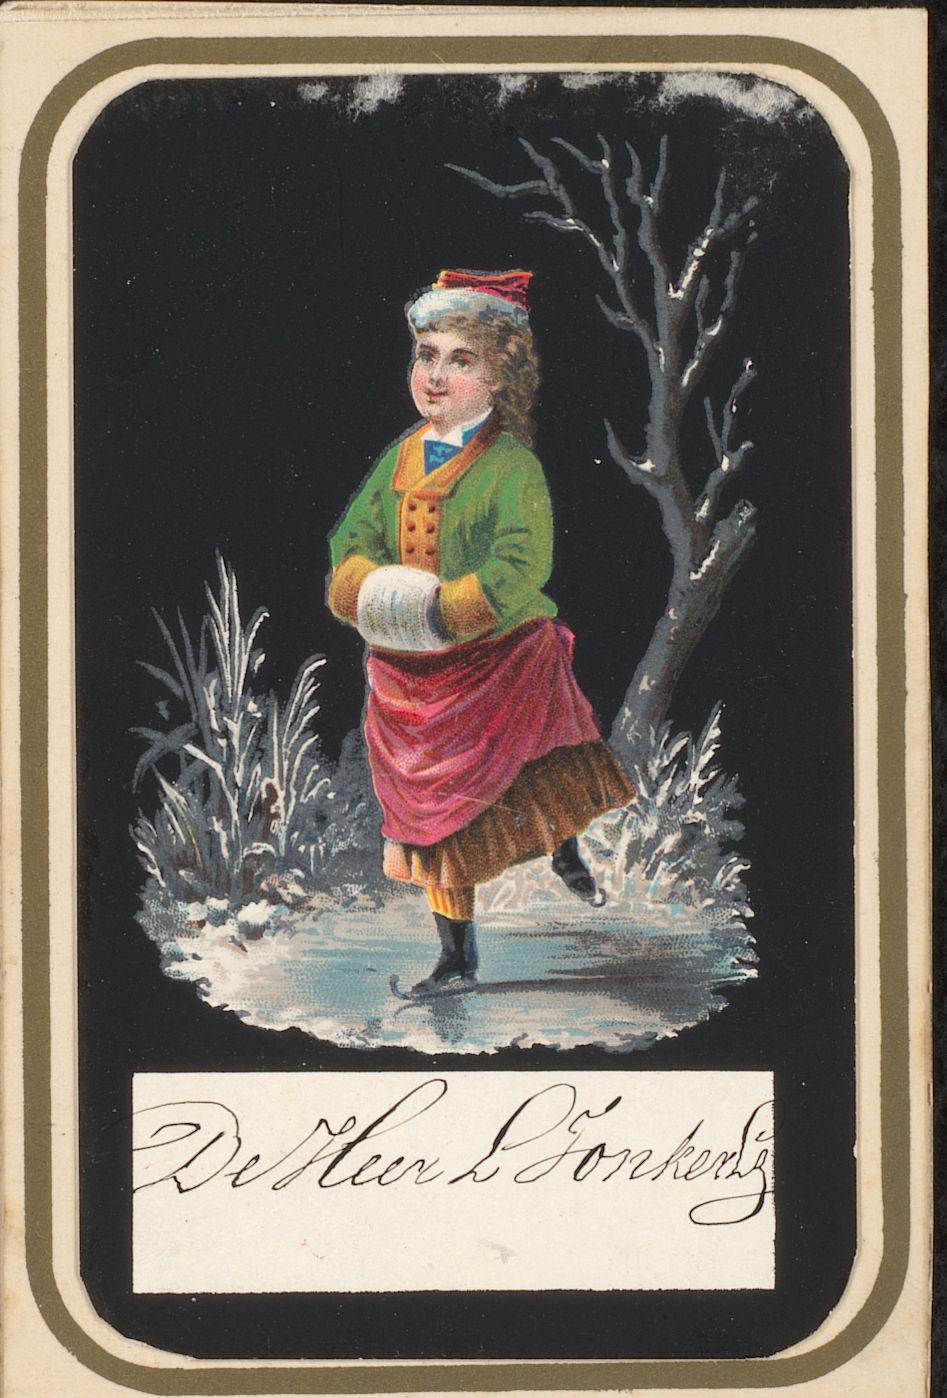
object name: print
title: Menu voor het diner ter ere van het gouden huwelijksjubileum van Lucas Jonker en Maria Engelina van Zijp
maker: Anonymous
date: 1878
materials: paper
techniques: chromolithography, printing block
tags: skates (winter sports), golden anniversary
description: Op de voorzijde een wintertafereel met schaatsende vrouw. Daaronder de naam van de genodigde: 'De Heer L. Jonker Lz.n'. Binnenin het menu en een decoratie van een vaas of mand met bloemen en fruit. Op de achterzijde details over het diner en het jubileum, gevierd op 27 juli 1878.